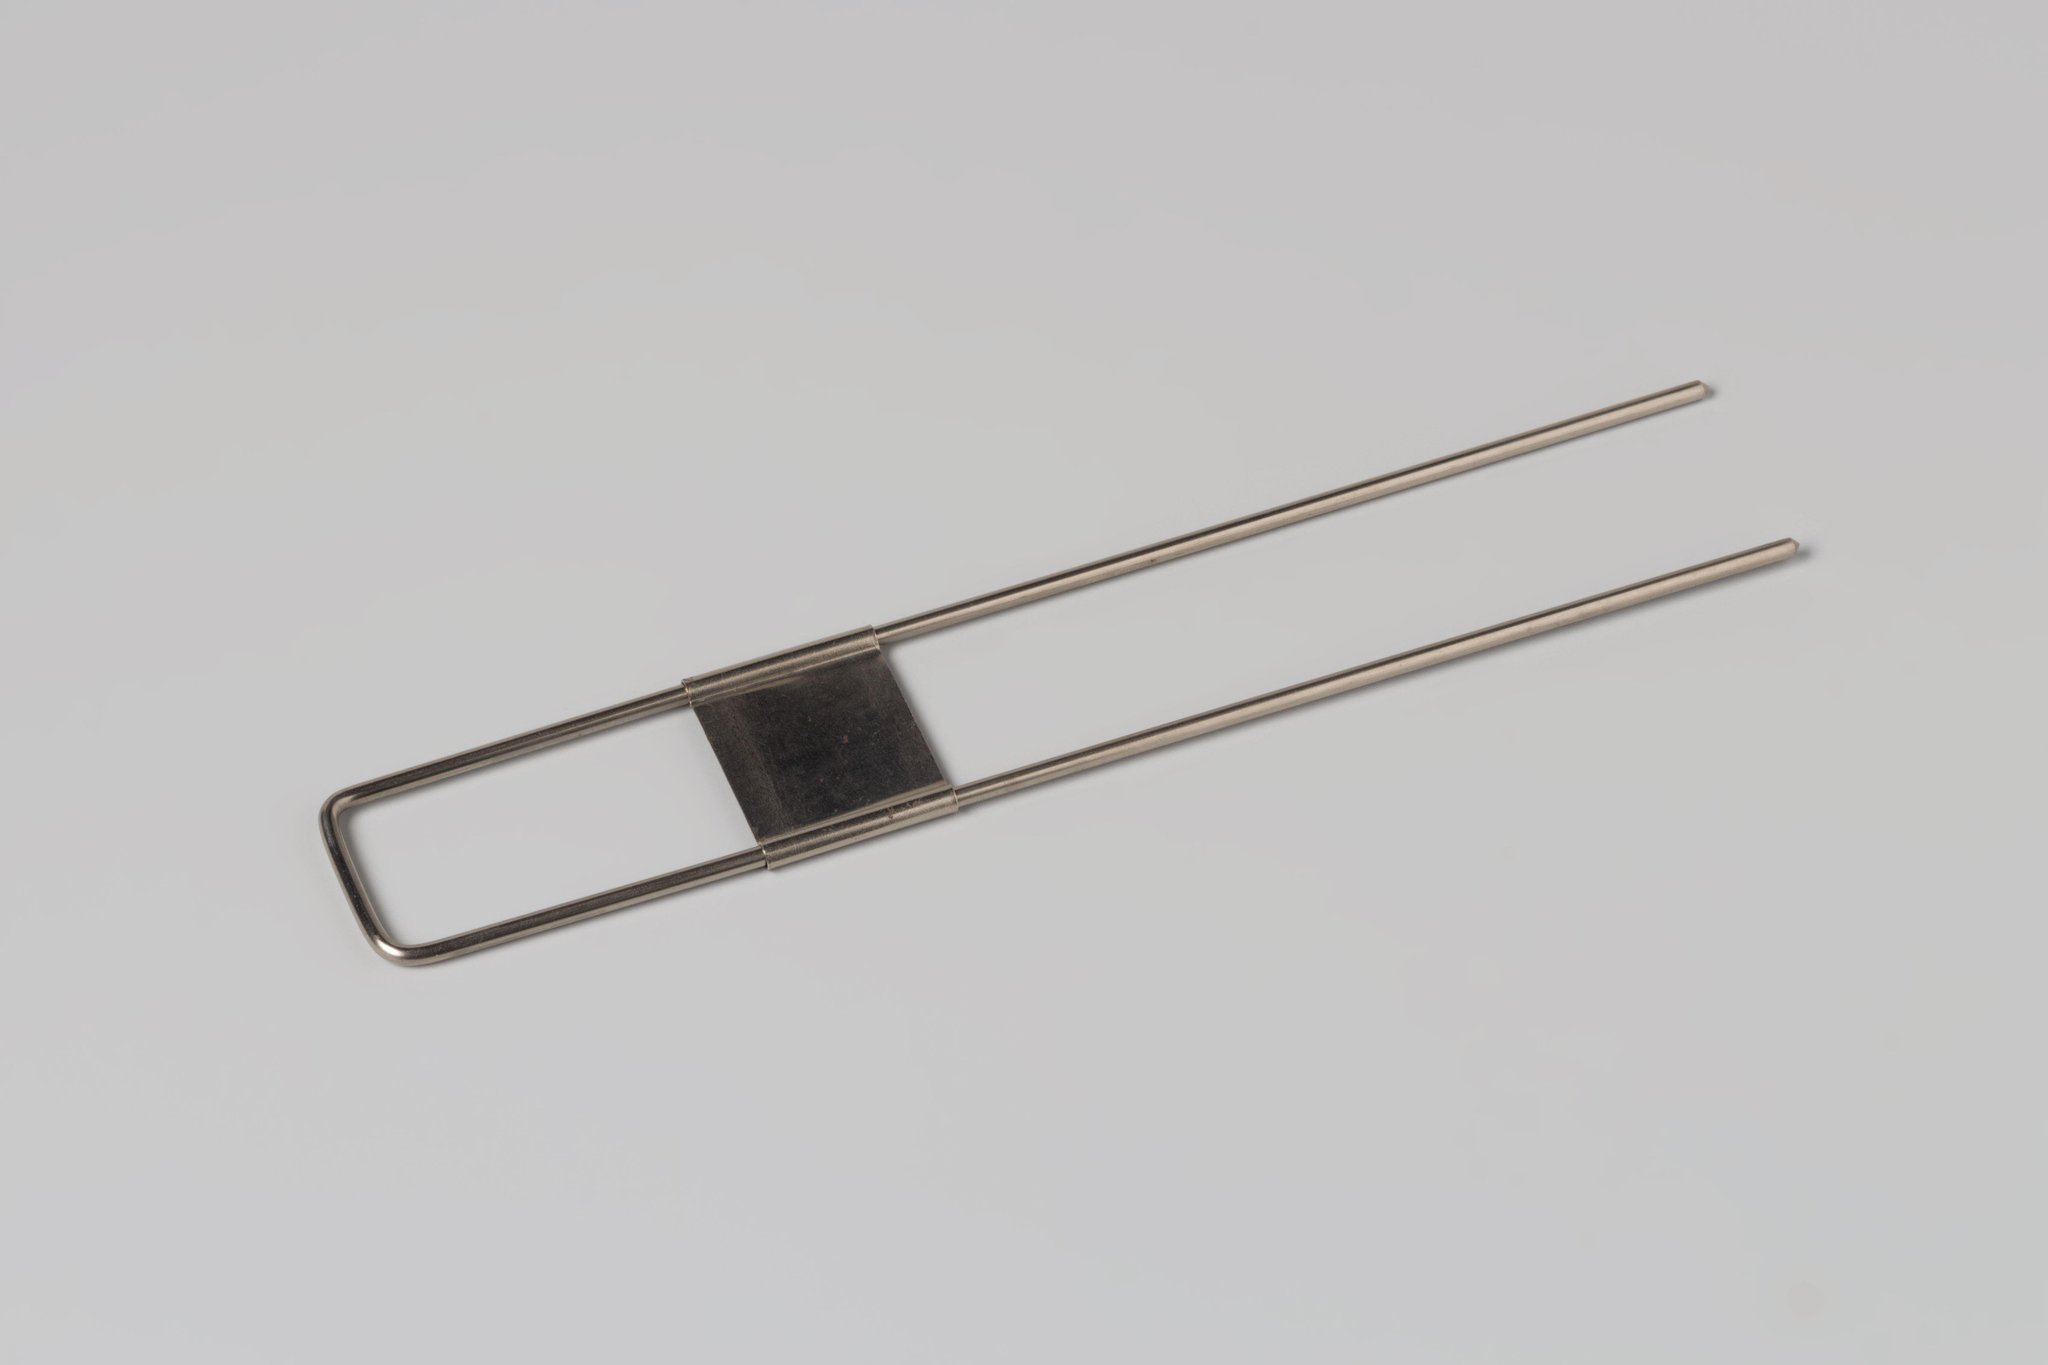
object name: handwerkgerei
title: Een pen van staaldraad, U-vormig met een schuifplaatje, voor haarspeld-haakwerk, guimpewerk of hairpinwork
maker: Anonymous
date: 1900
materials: steel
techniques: forging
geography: netherlands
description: Een pen van staaldraad, U-vormig met een schuifplaatje, voor haarspeld-haakwerk, guimpewerk of hairpinwork.